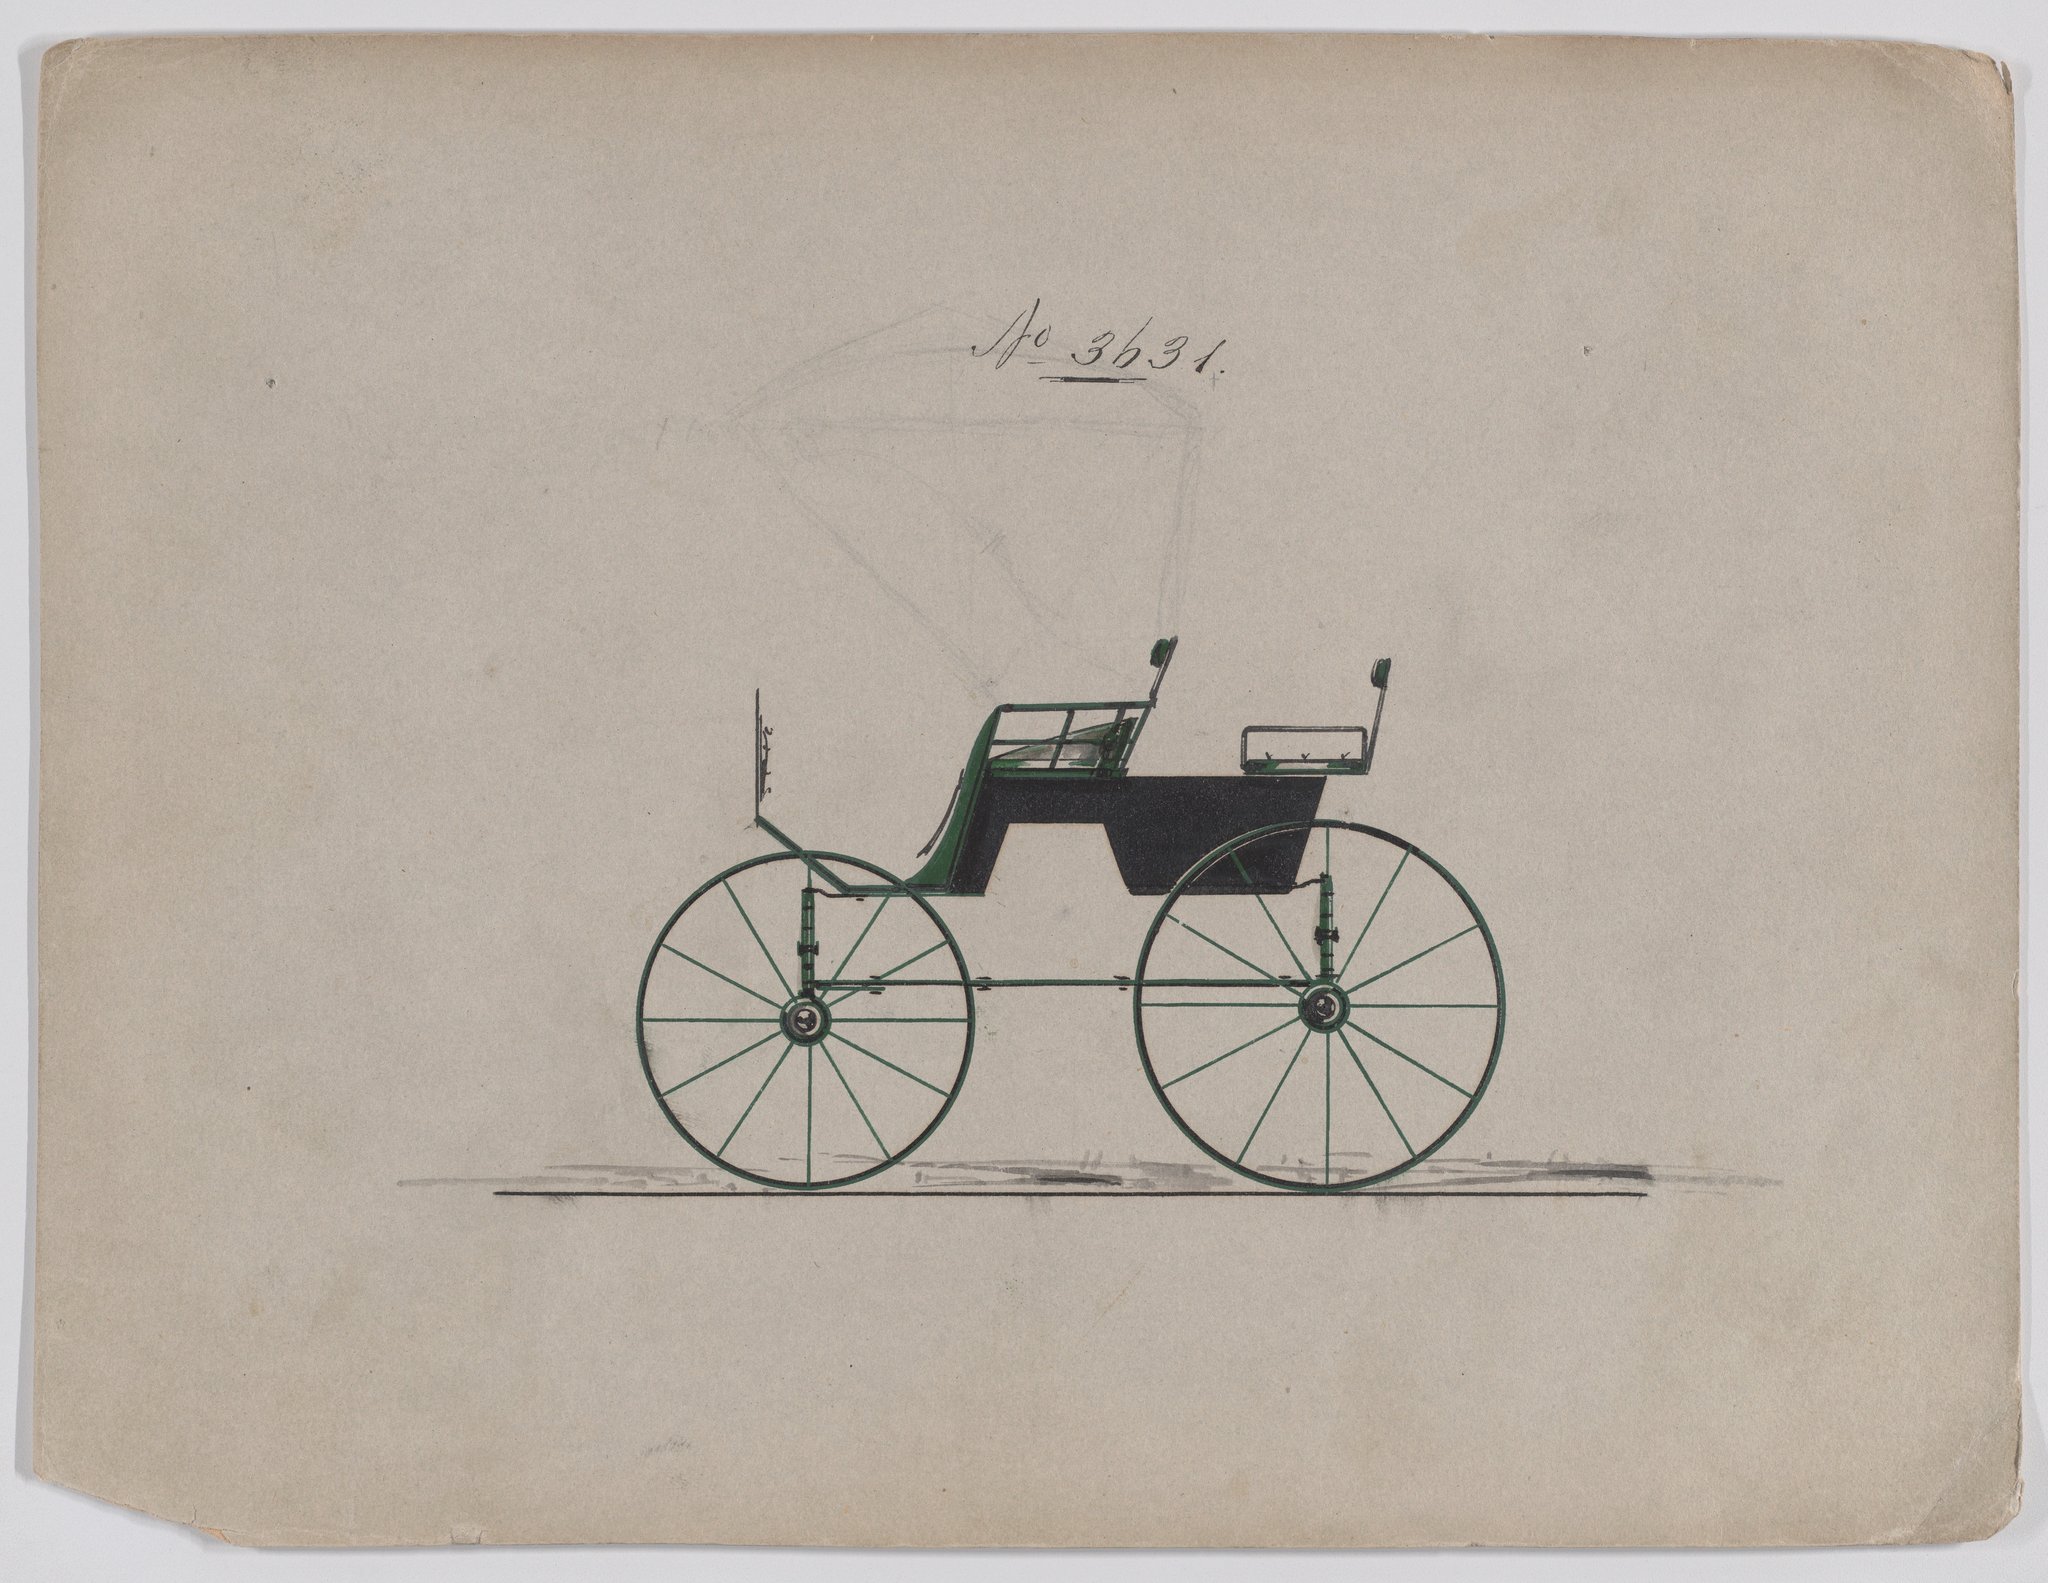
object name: drawing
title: Design for a Phaeton, no. 3631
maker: brewster & co.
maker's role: manufacturer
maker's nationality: american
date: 1880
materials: graphite, ink, watercolor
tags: carriages